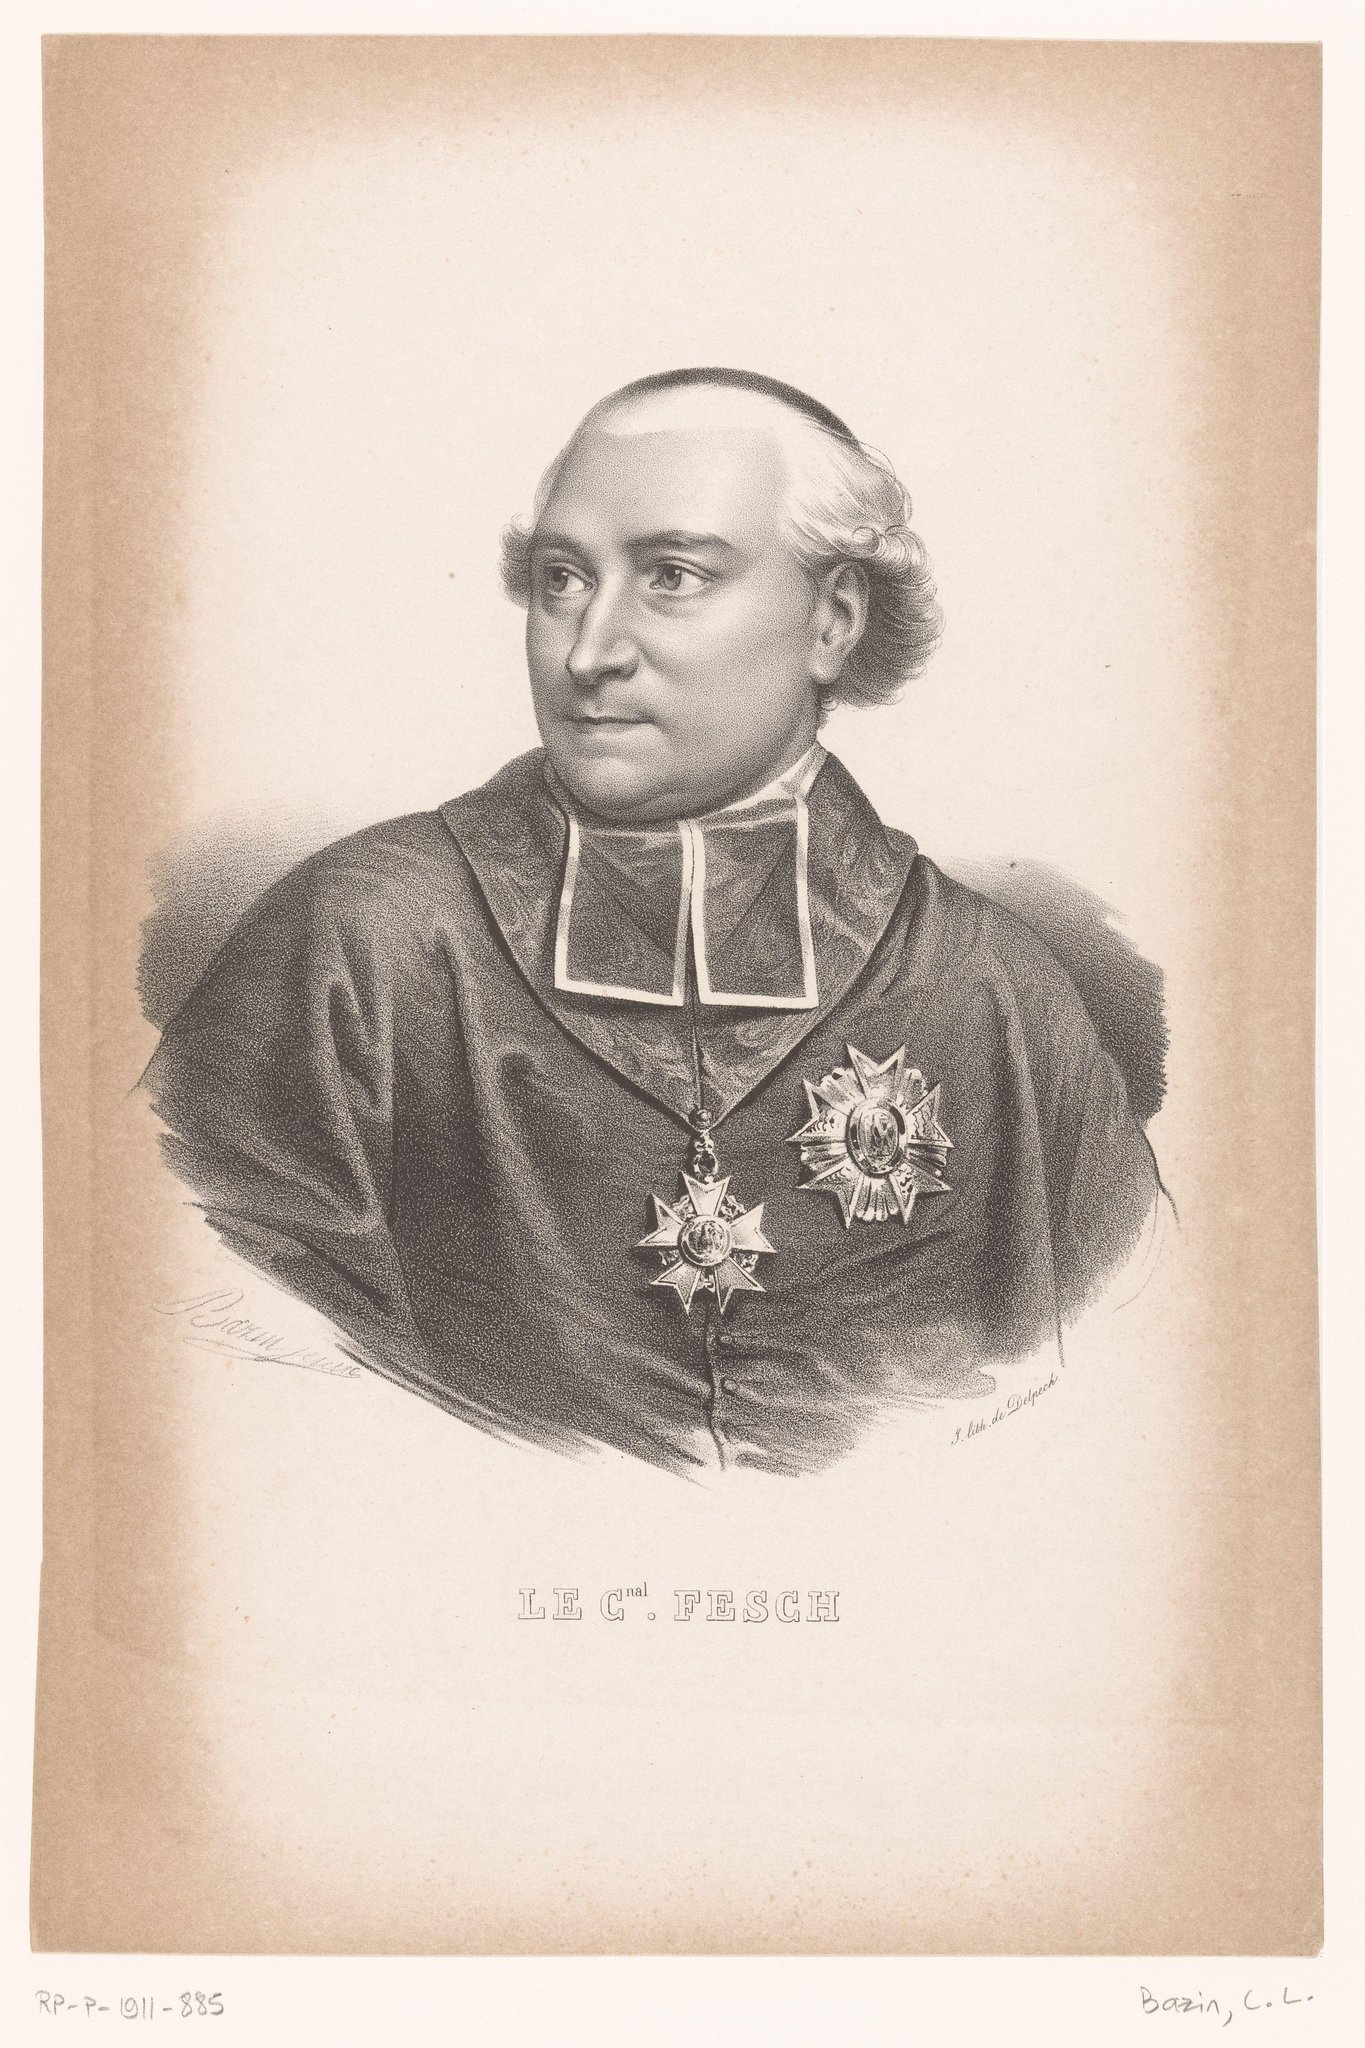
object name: print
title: Le C.nal. Fesch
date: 1830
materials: paper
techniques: lithograph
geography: paris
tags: historical persons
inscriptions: collector's mark: Lugt 2228a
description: De serie Iconographie des contemporains depuis 1789 jusqu'à 1820 is uitgegeven tussen 1822 en 1833 in verschillende livraisons.